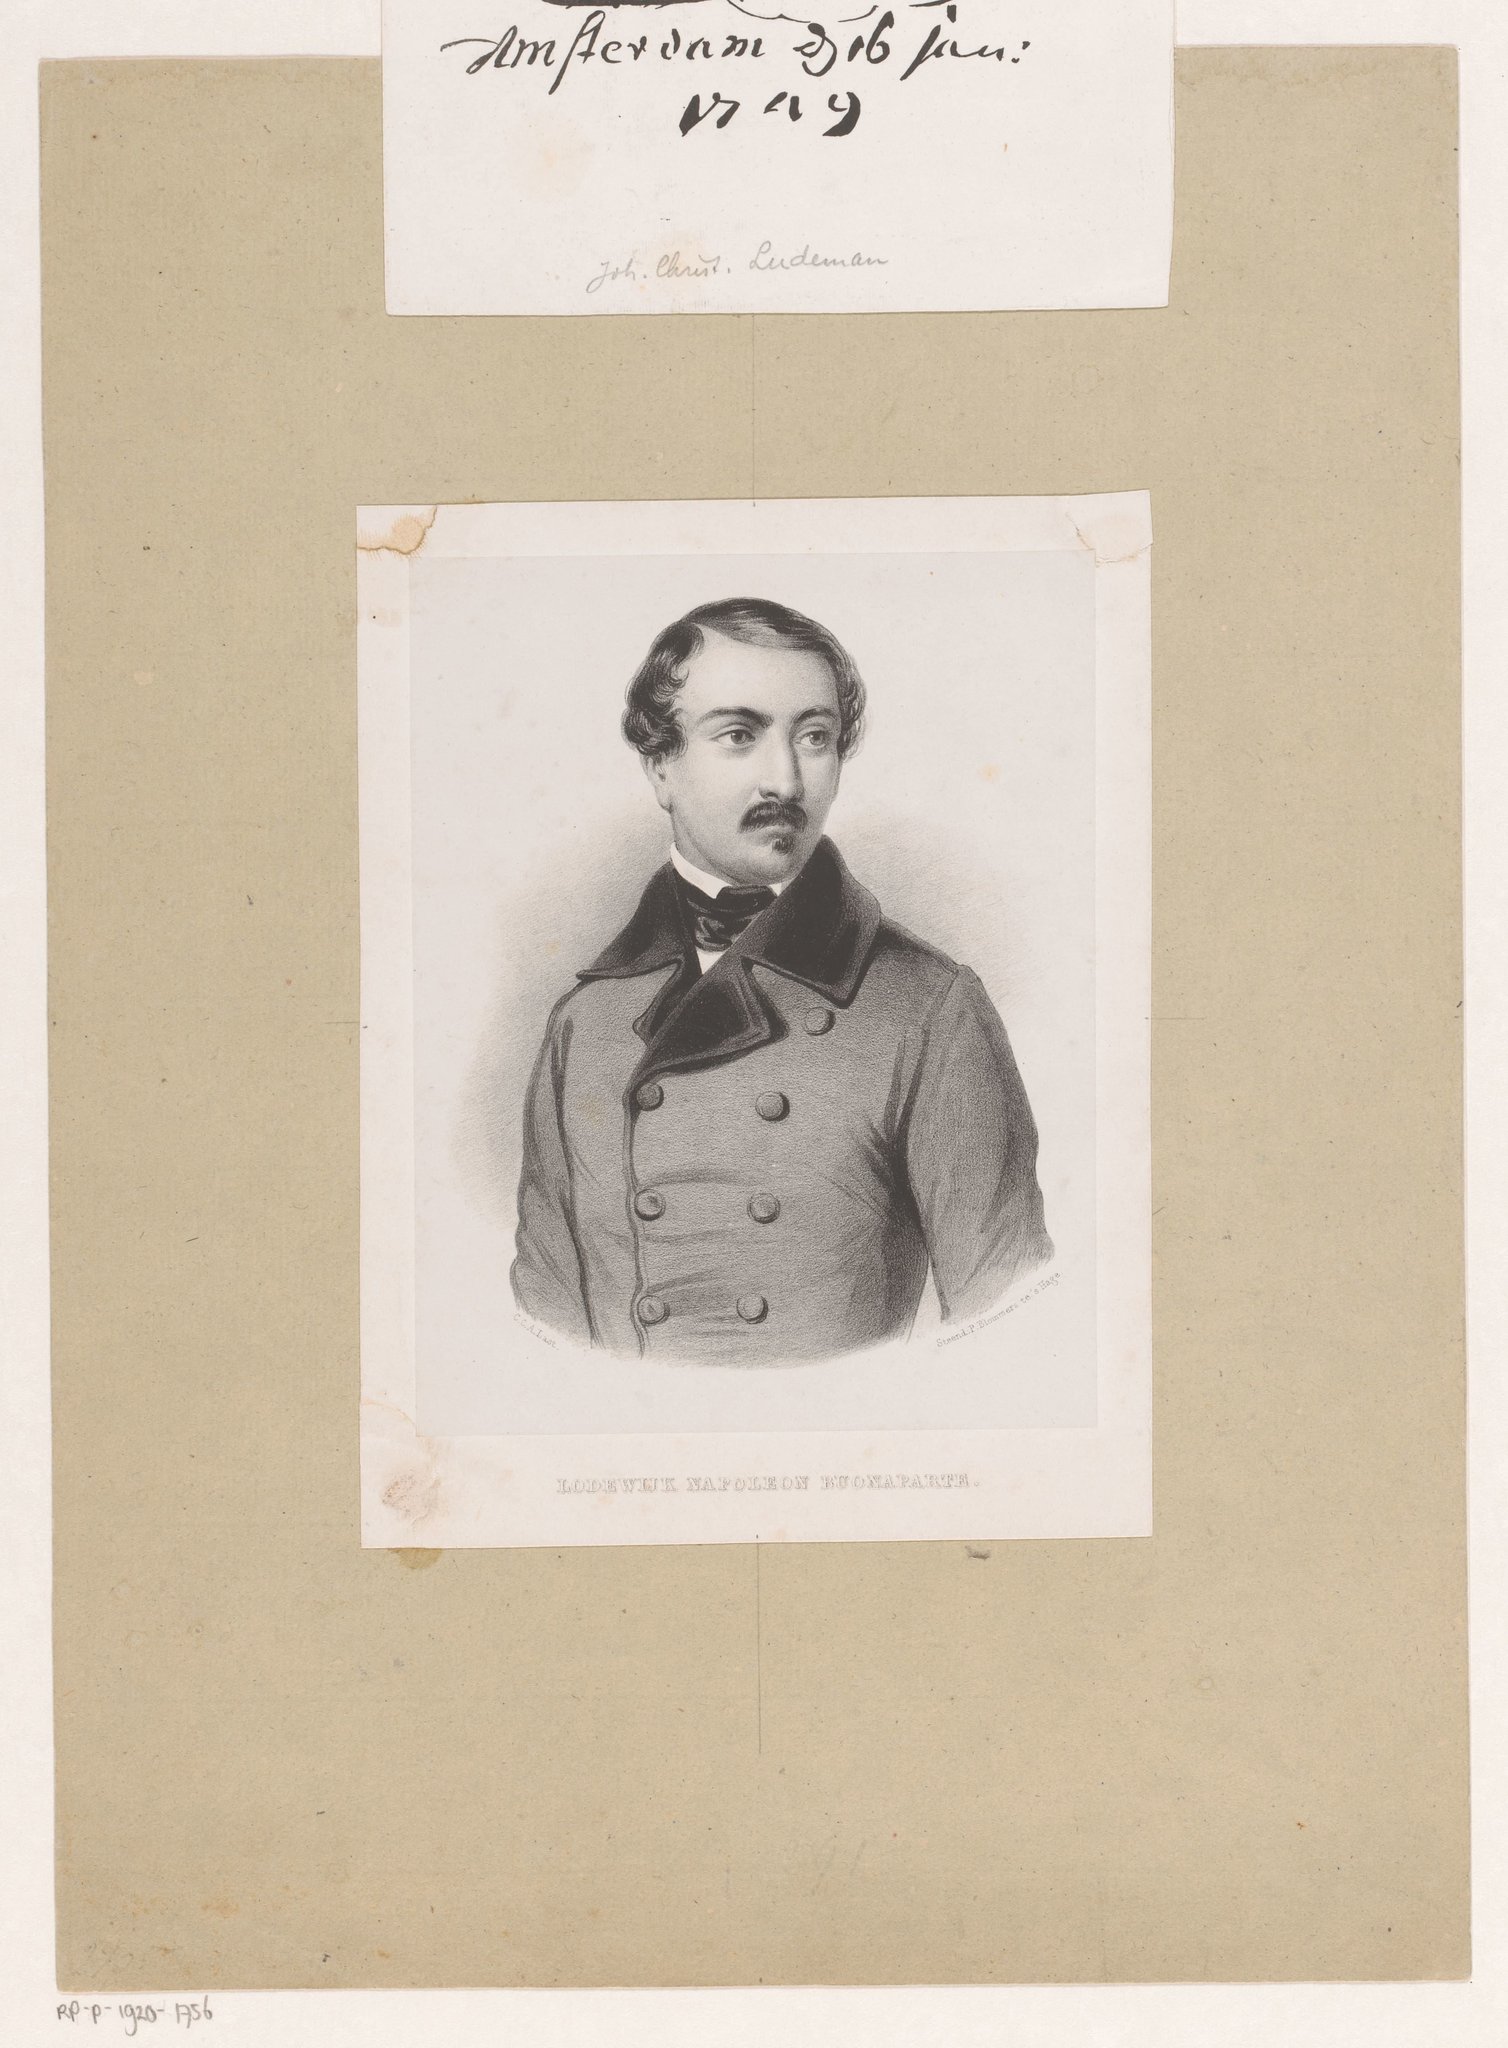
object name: print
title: Portret van Karel Lodewijk Napoleon Bonaparte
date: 1818-1887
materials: paper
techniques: lithograph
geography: netherlands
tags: paris, london, napoleon iii (keizer der fransen), historical persons (+ (full) bust portrait)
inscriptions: collector's mark: Lugt 2228